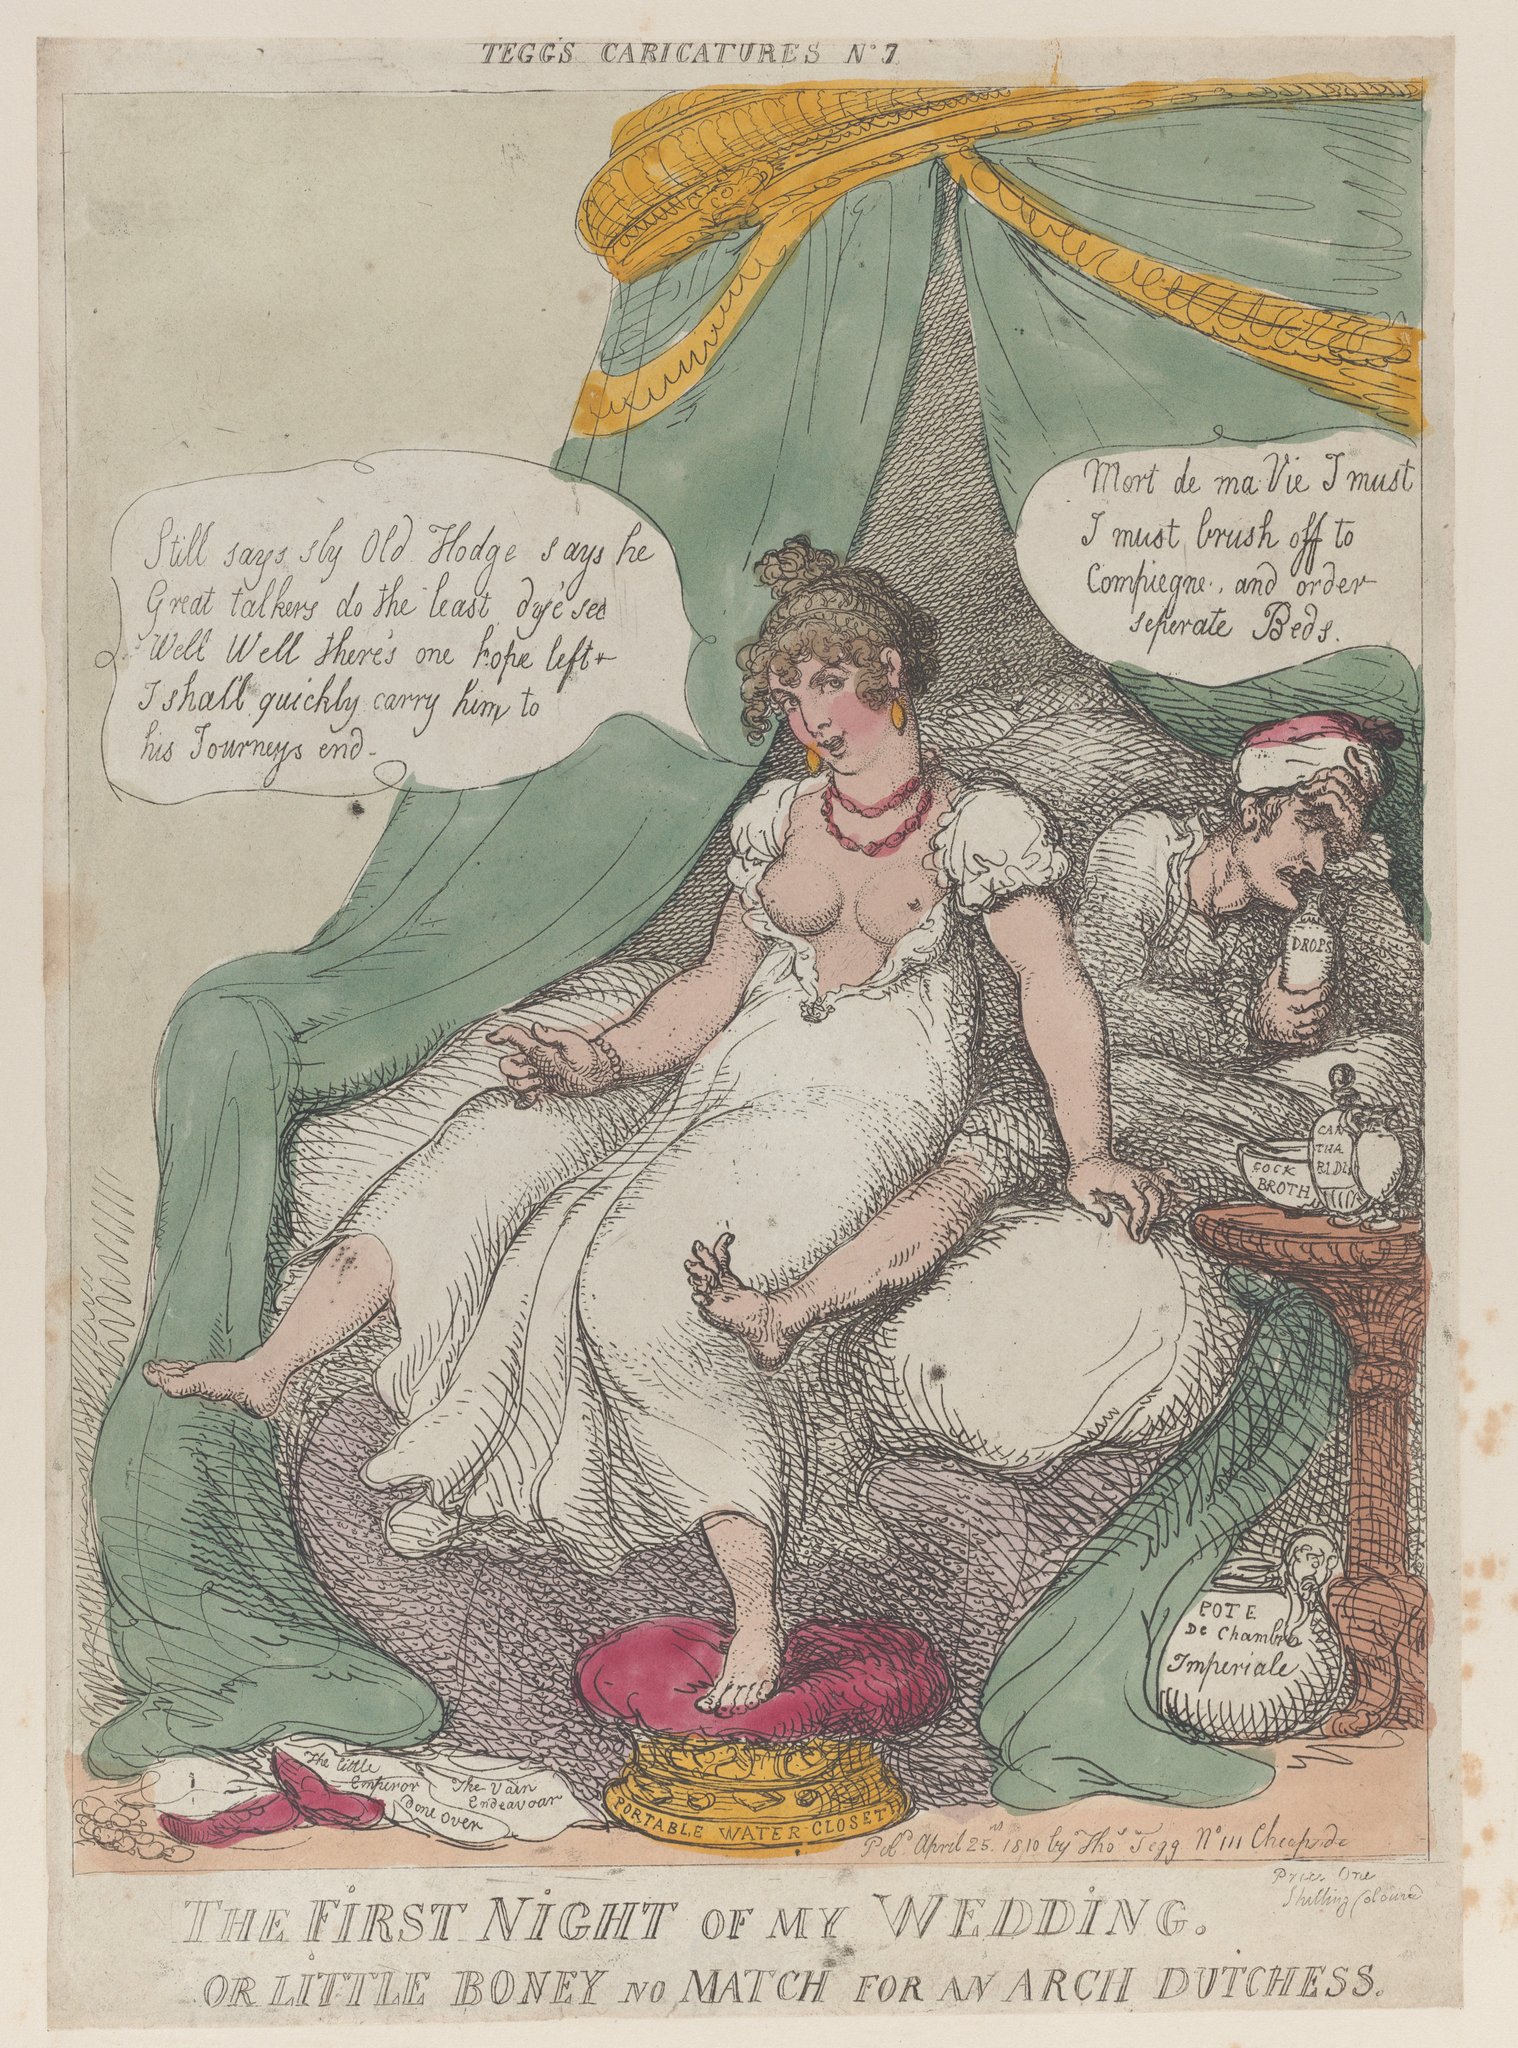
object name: print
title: The First Night of My Wedding, or Little Boney No Match For an Arch Dutchess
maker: thomas rowlandson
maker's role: artist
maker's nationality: british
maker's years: 1757-1827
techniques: etching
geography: london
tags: satire,napoleon i,men,women,beds